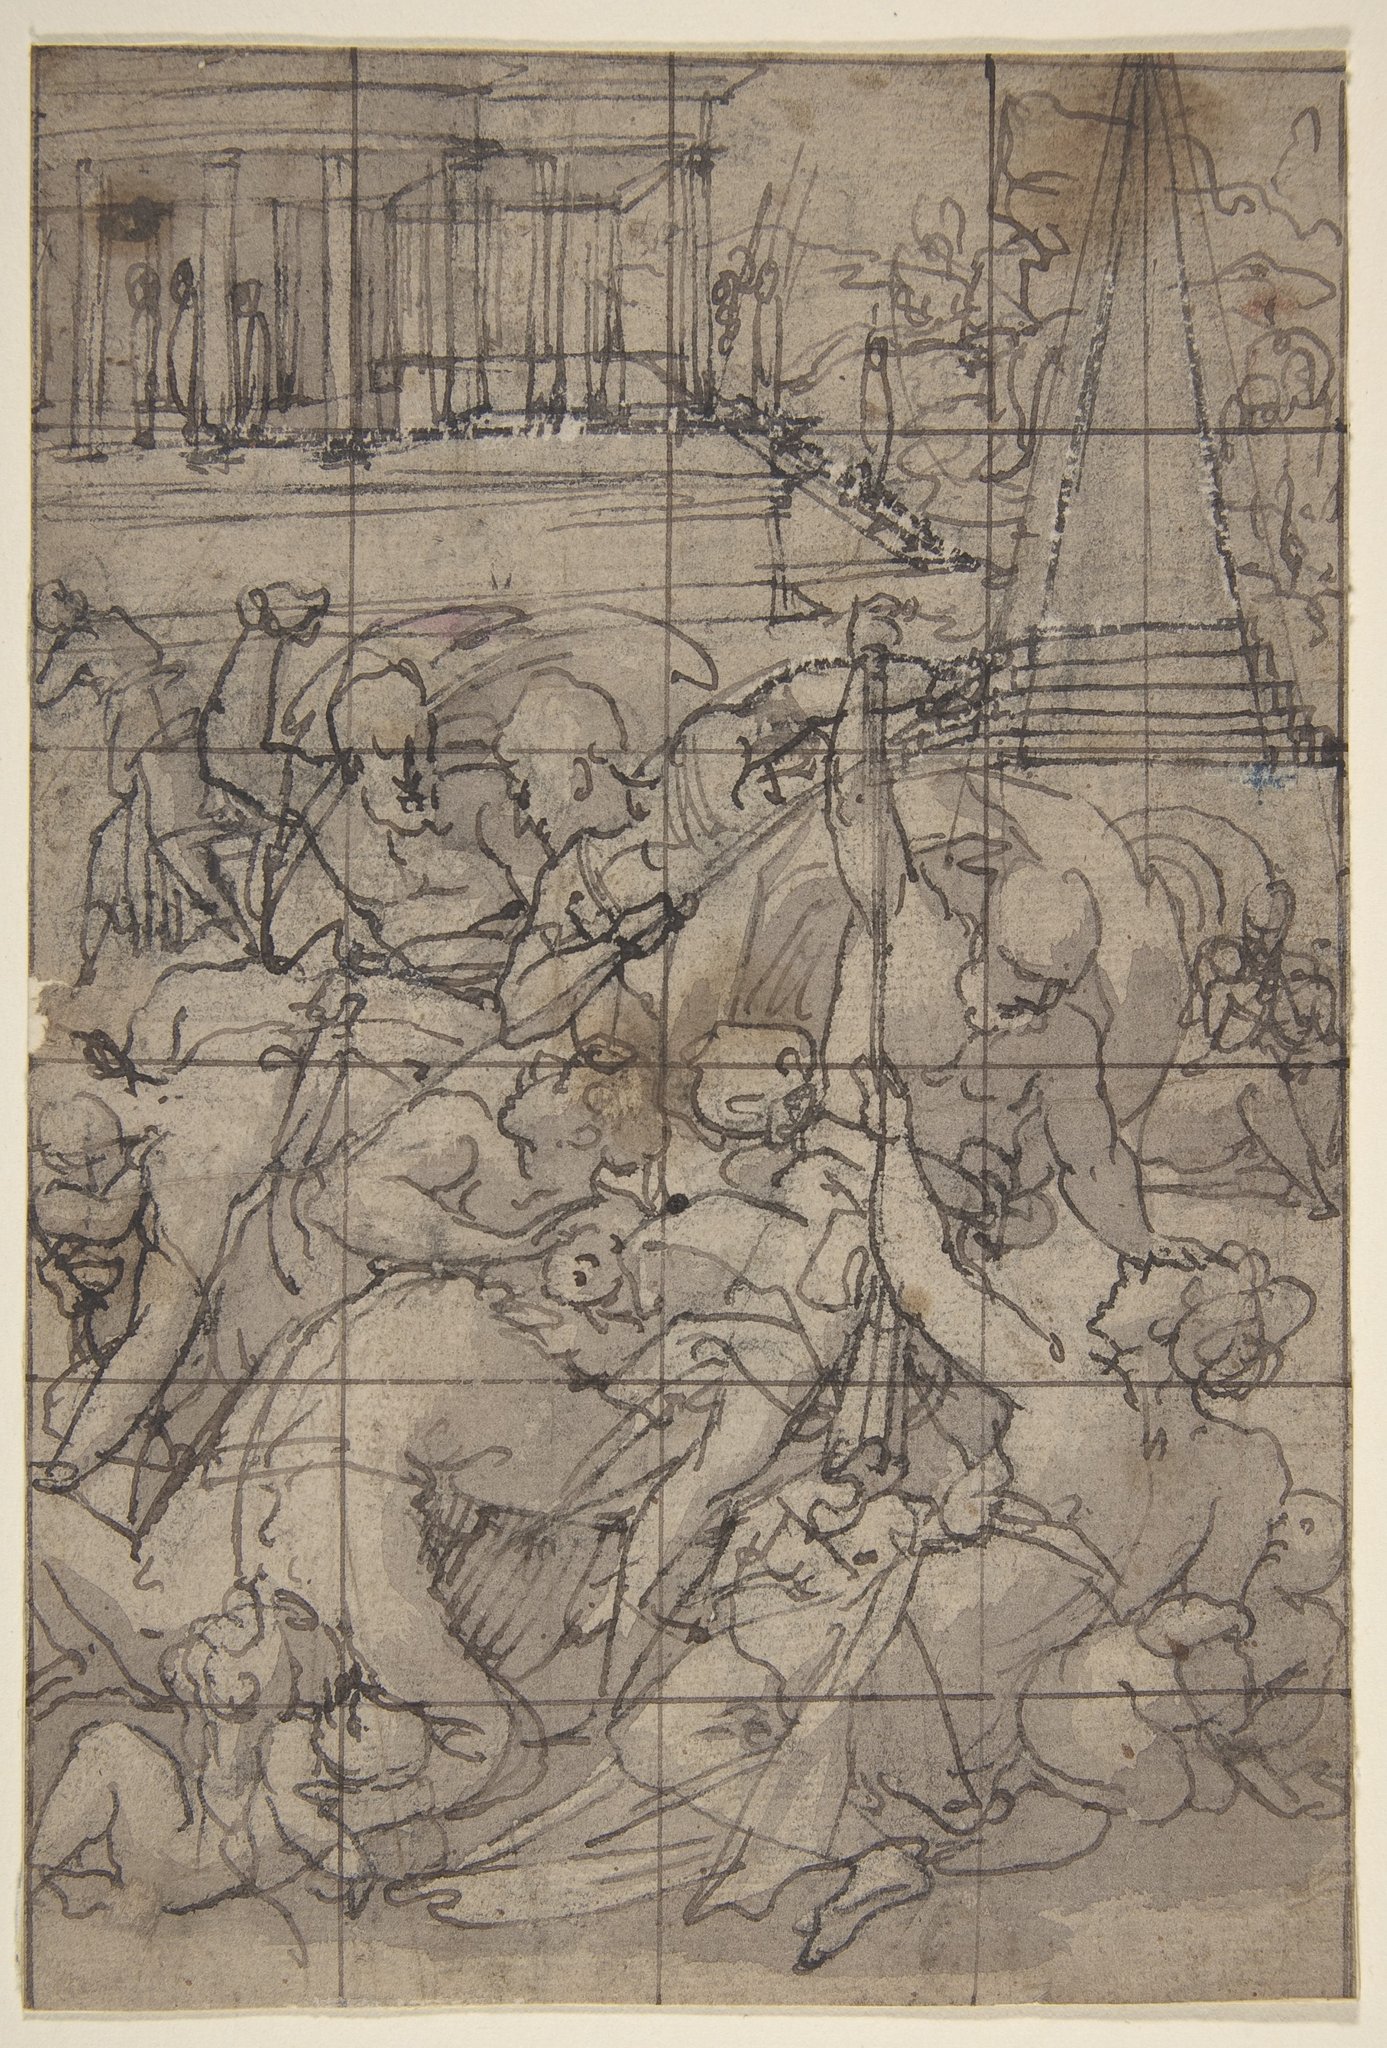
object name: drawing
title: Study for a Massacre of the Innocents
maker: domenico cresti passignano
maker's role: artist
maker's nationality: italian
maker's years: 1560-1636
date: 1560-1636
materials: chalk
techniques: pen, wash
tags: human figures,massacres